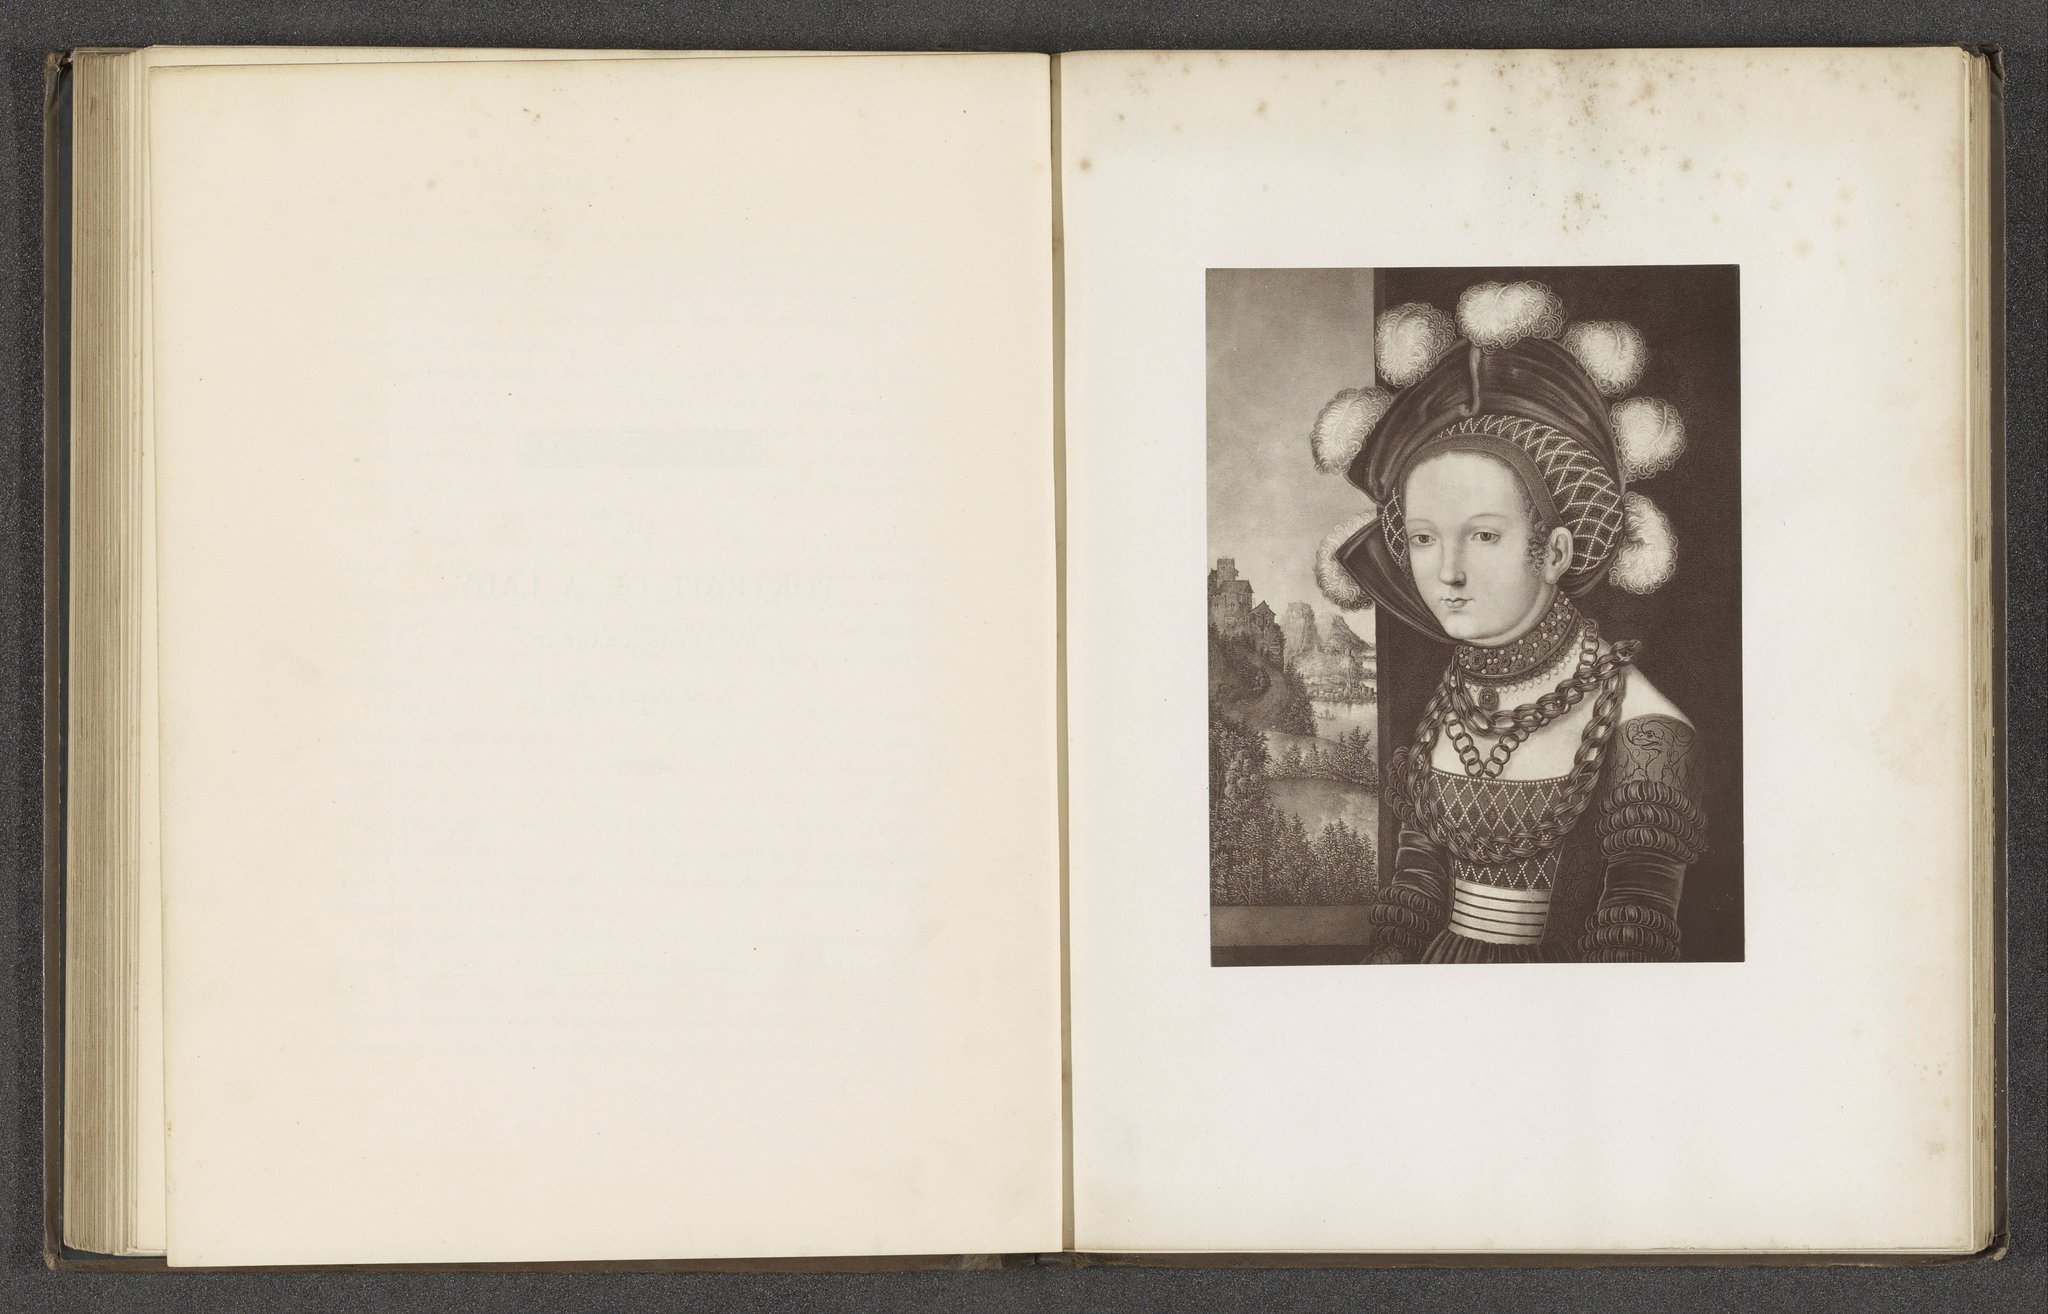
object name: page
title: Fotoreproductie van een prent naar een schilderij, voorstellende een hofdame verkleed als Salomé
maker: Anonymous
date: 1859-1869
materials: paper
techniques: woodburytype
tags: salome (not in biblical context), historical persons not known by name - bb - woman